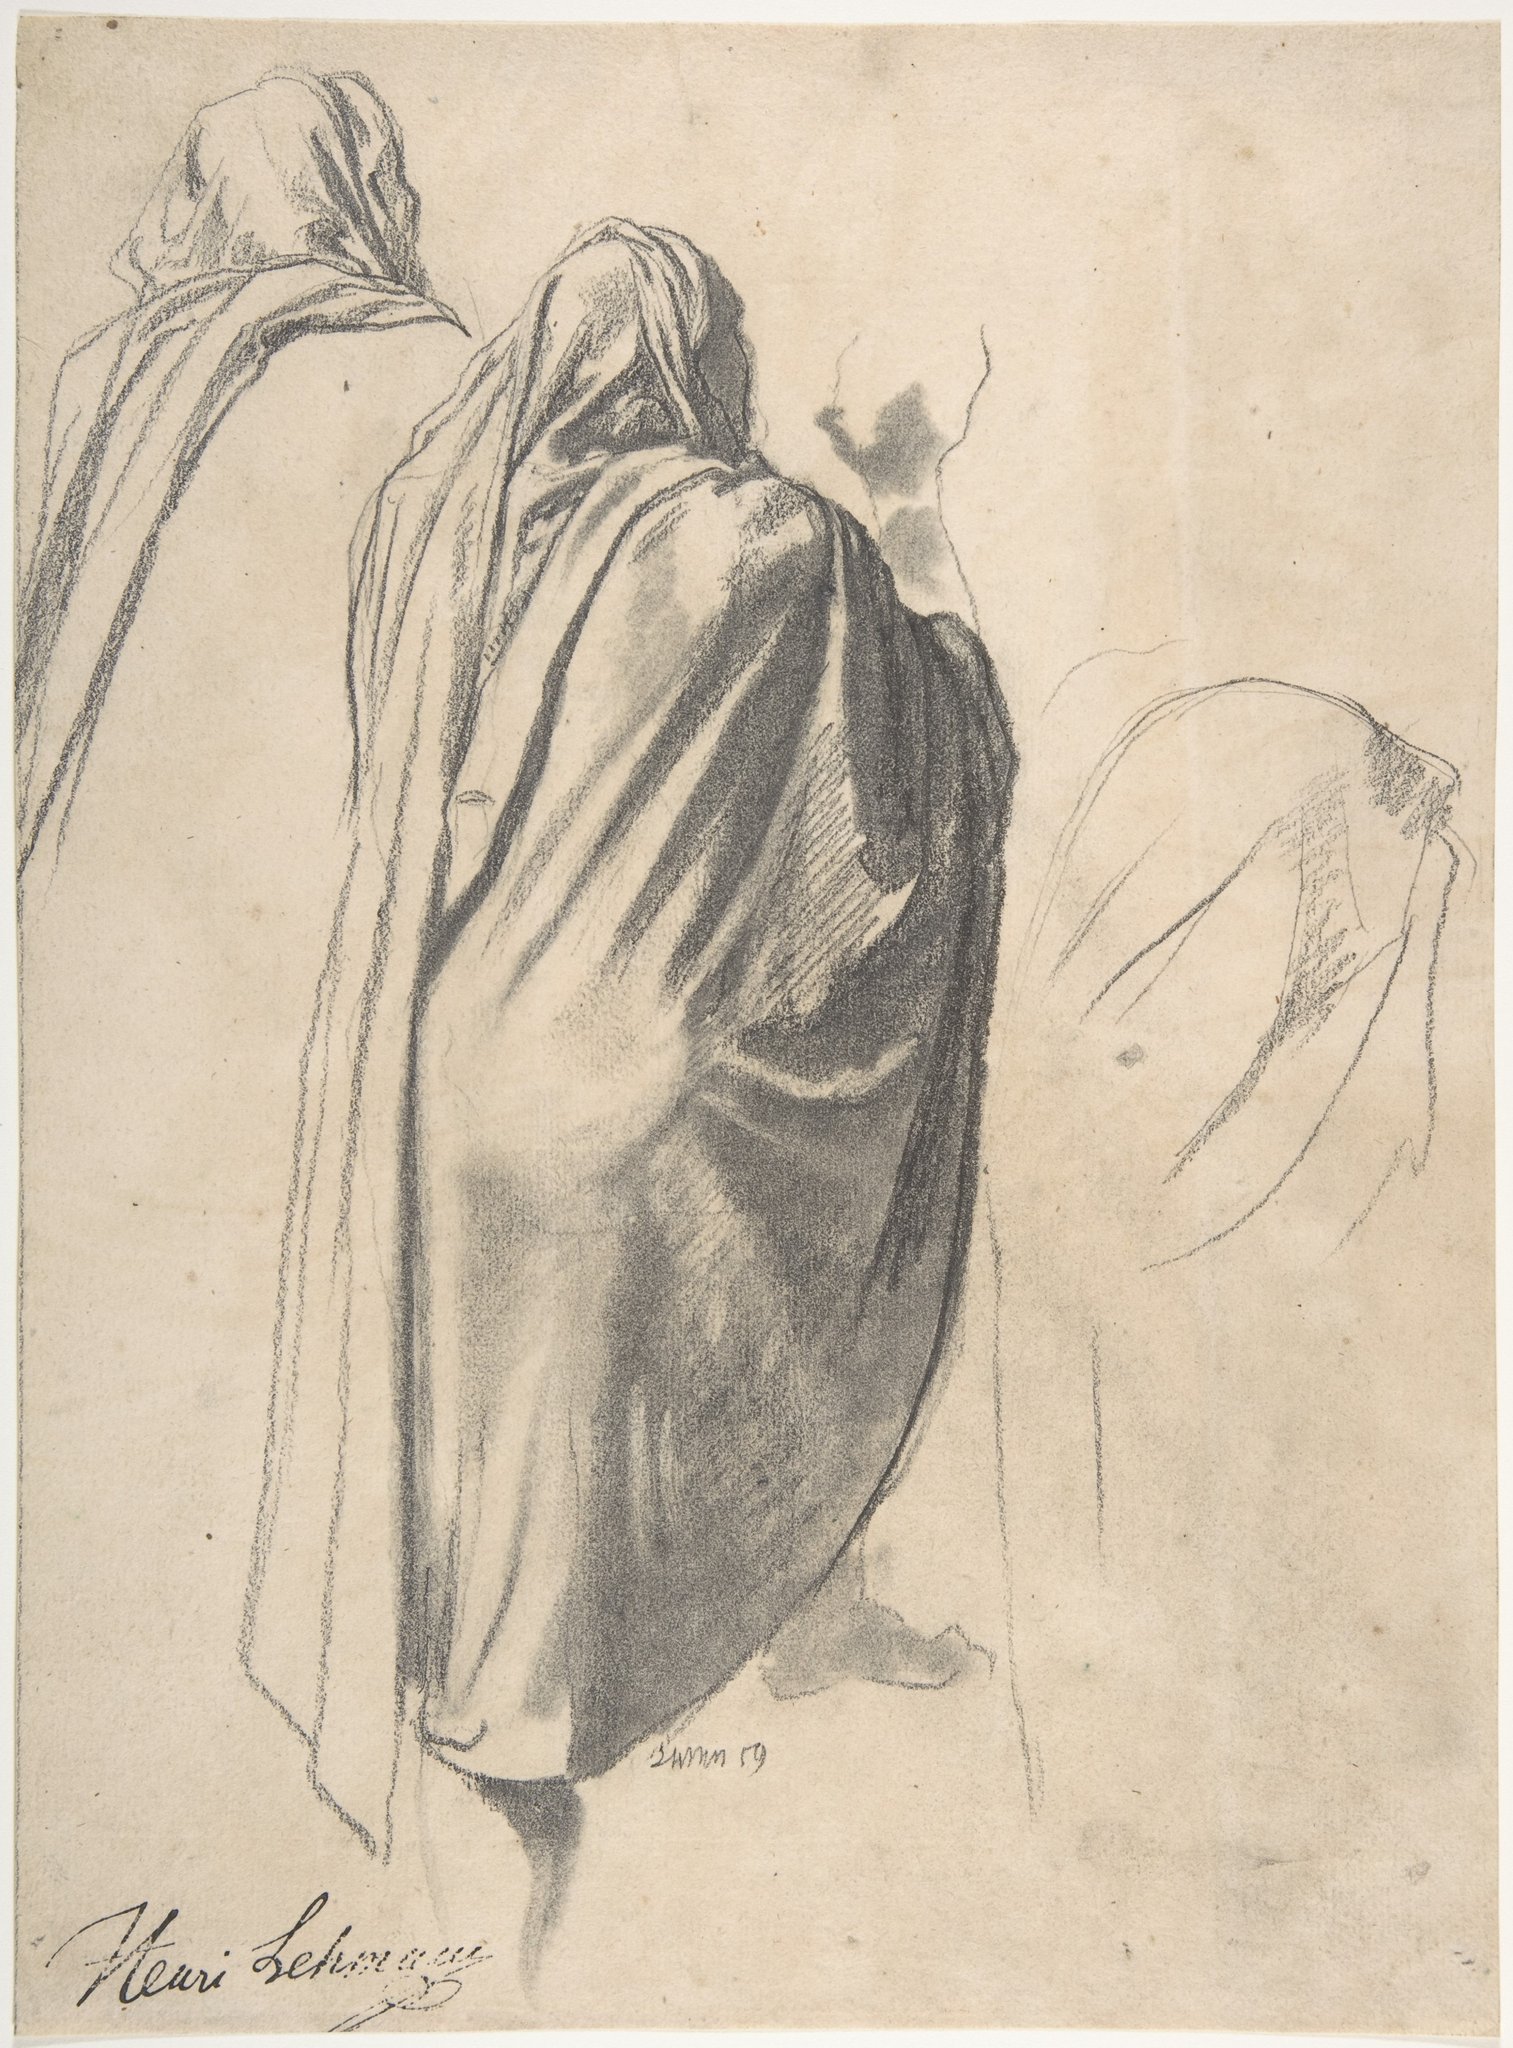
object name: drawing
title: Back View of a Male Figure Wearing a Cloak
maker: henri lehmann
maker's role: artist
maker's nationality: french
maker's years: 1814-1882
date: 1859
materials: graphite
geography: france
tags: men